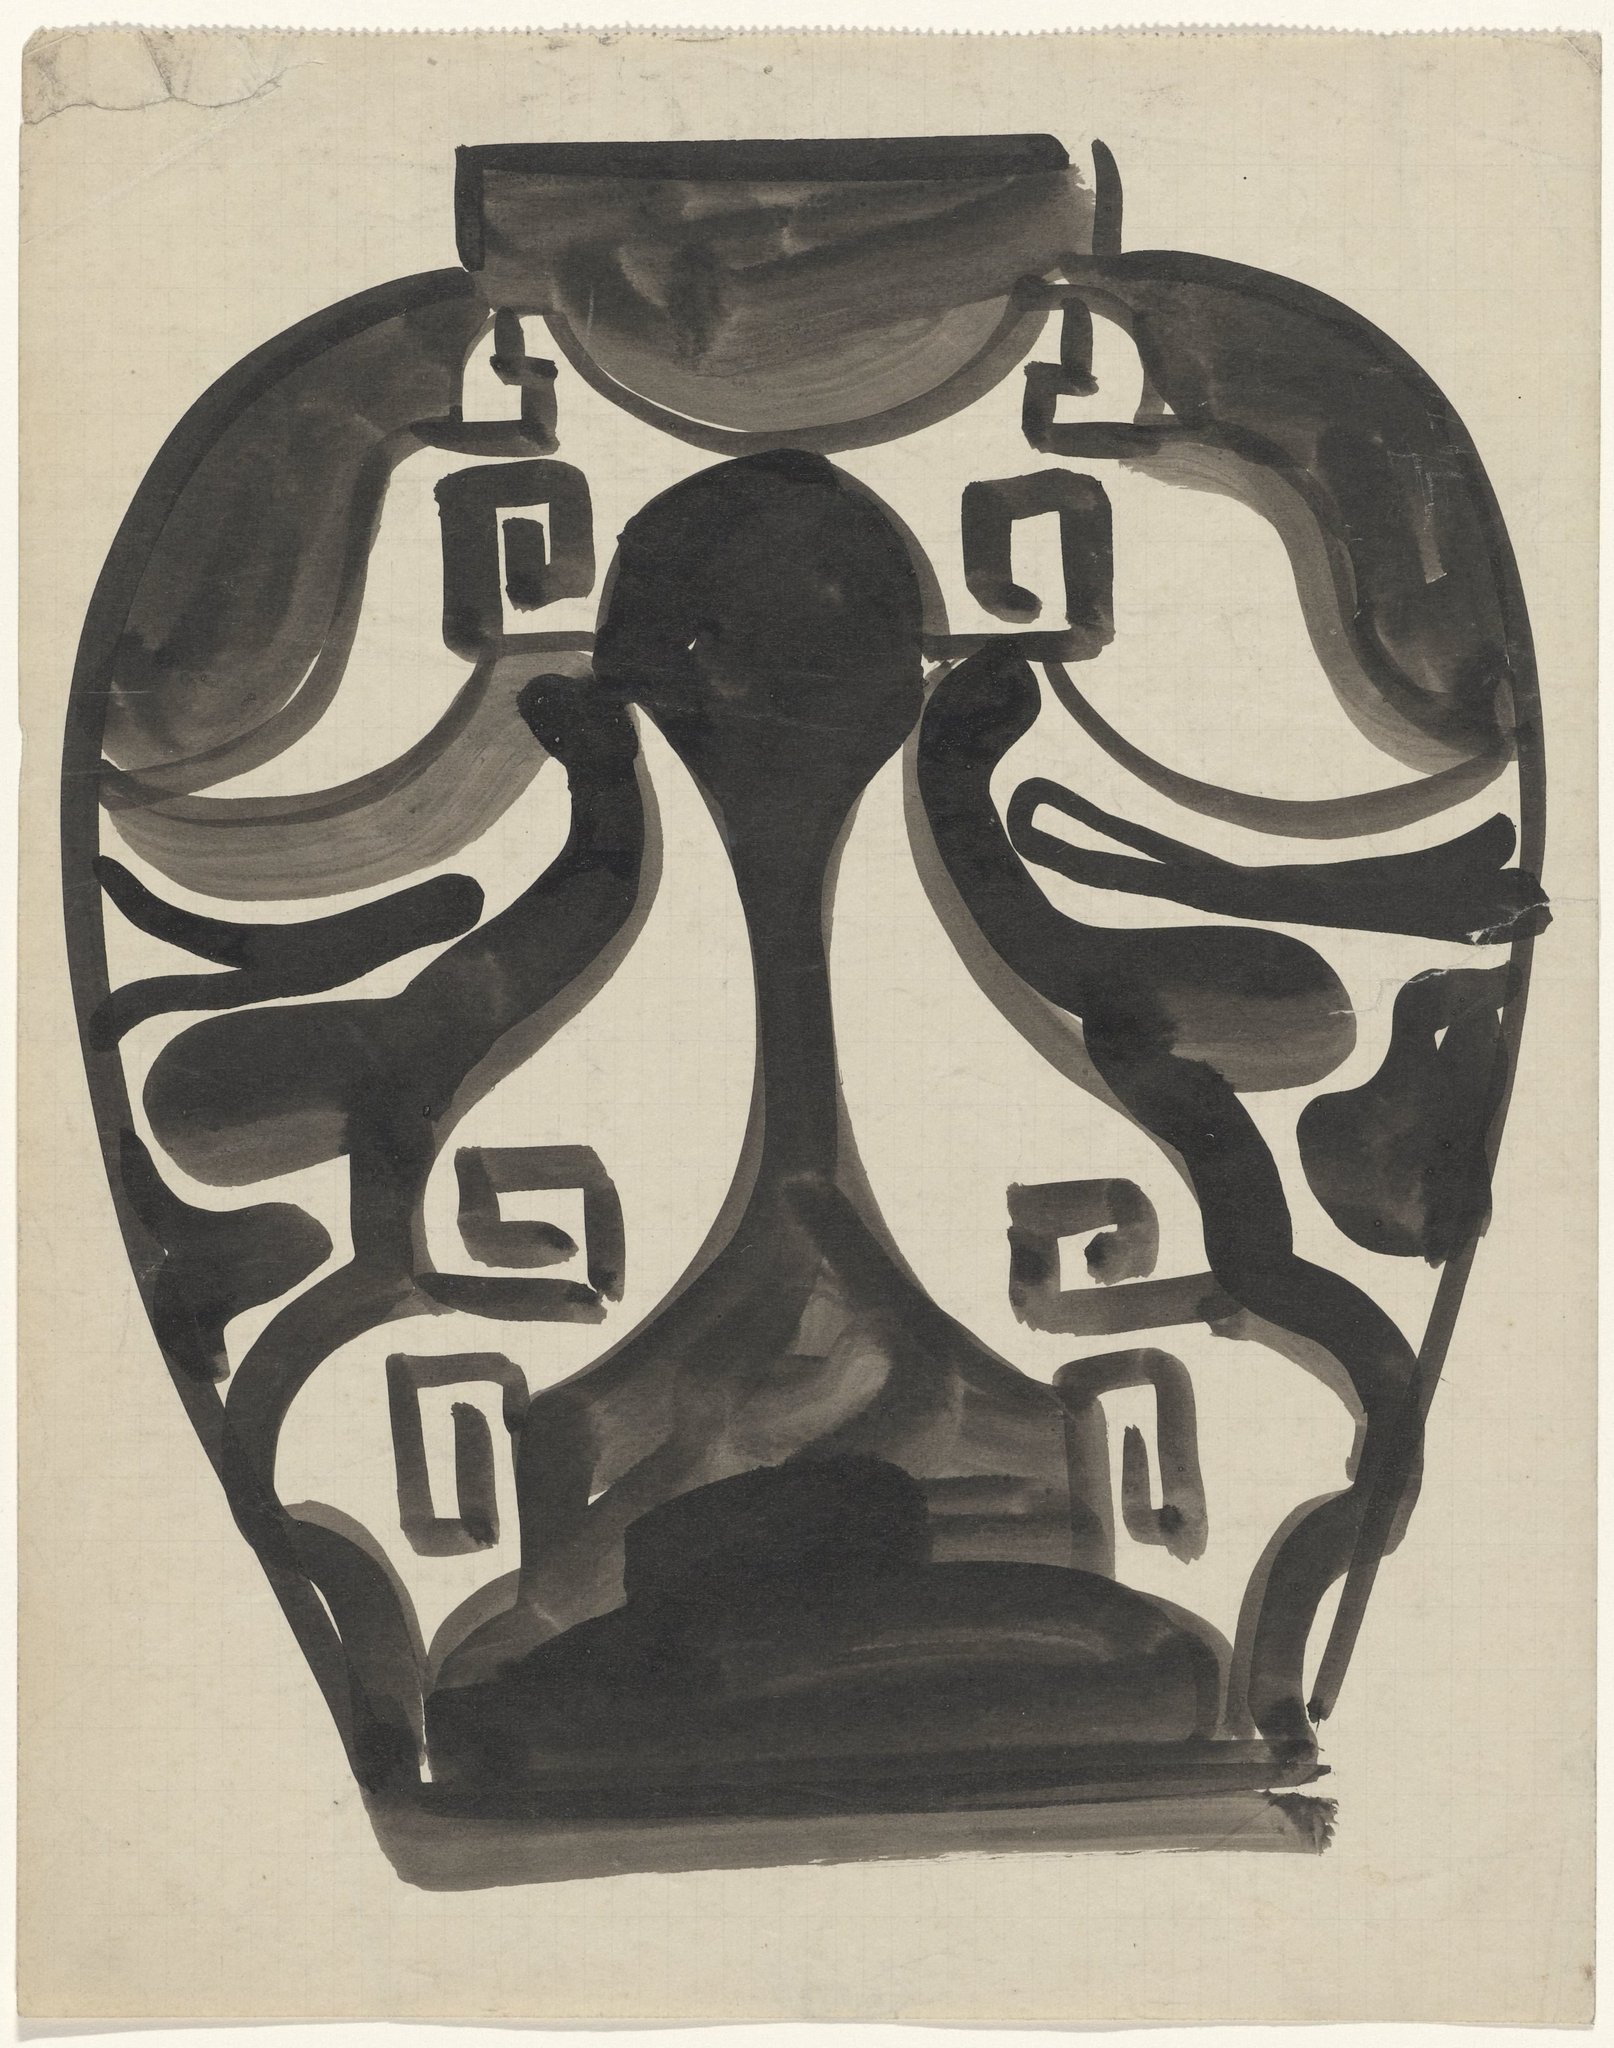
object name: design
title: Ontwerp voor een vaas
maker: carel adolph lion cachet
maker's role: draughtsman, print maker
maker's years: 1864-1945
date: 1874-1945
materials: squared paper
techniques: brush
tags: work of applied art (+ ceramics ~ arts), container of ceramics: jar, jug, pot, vase